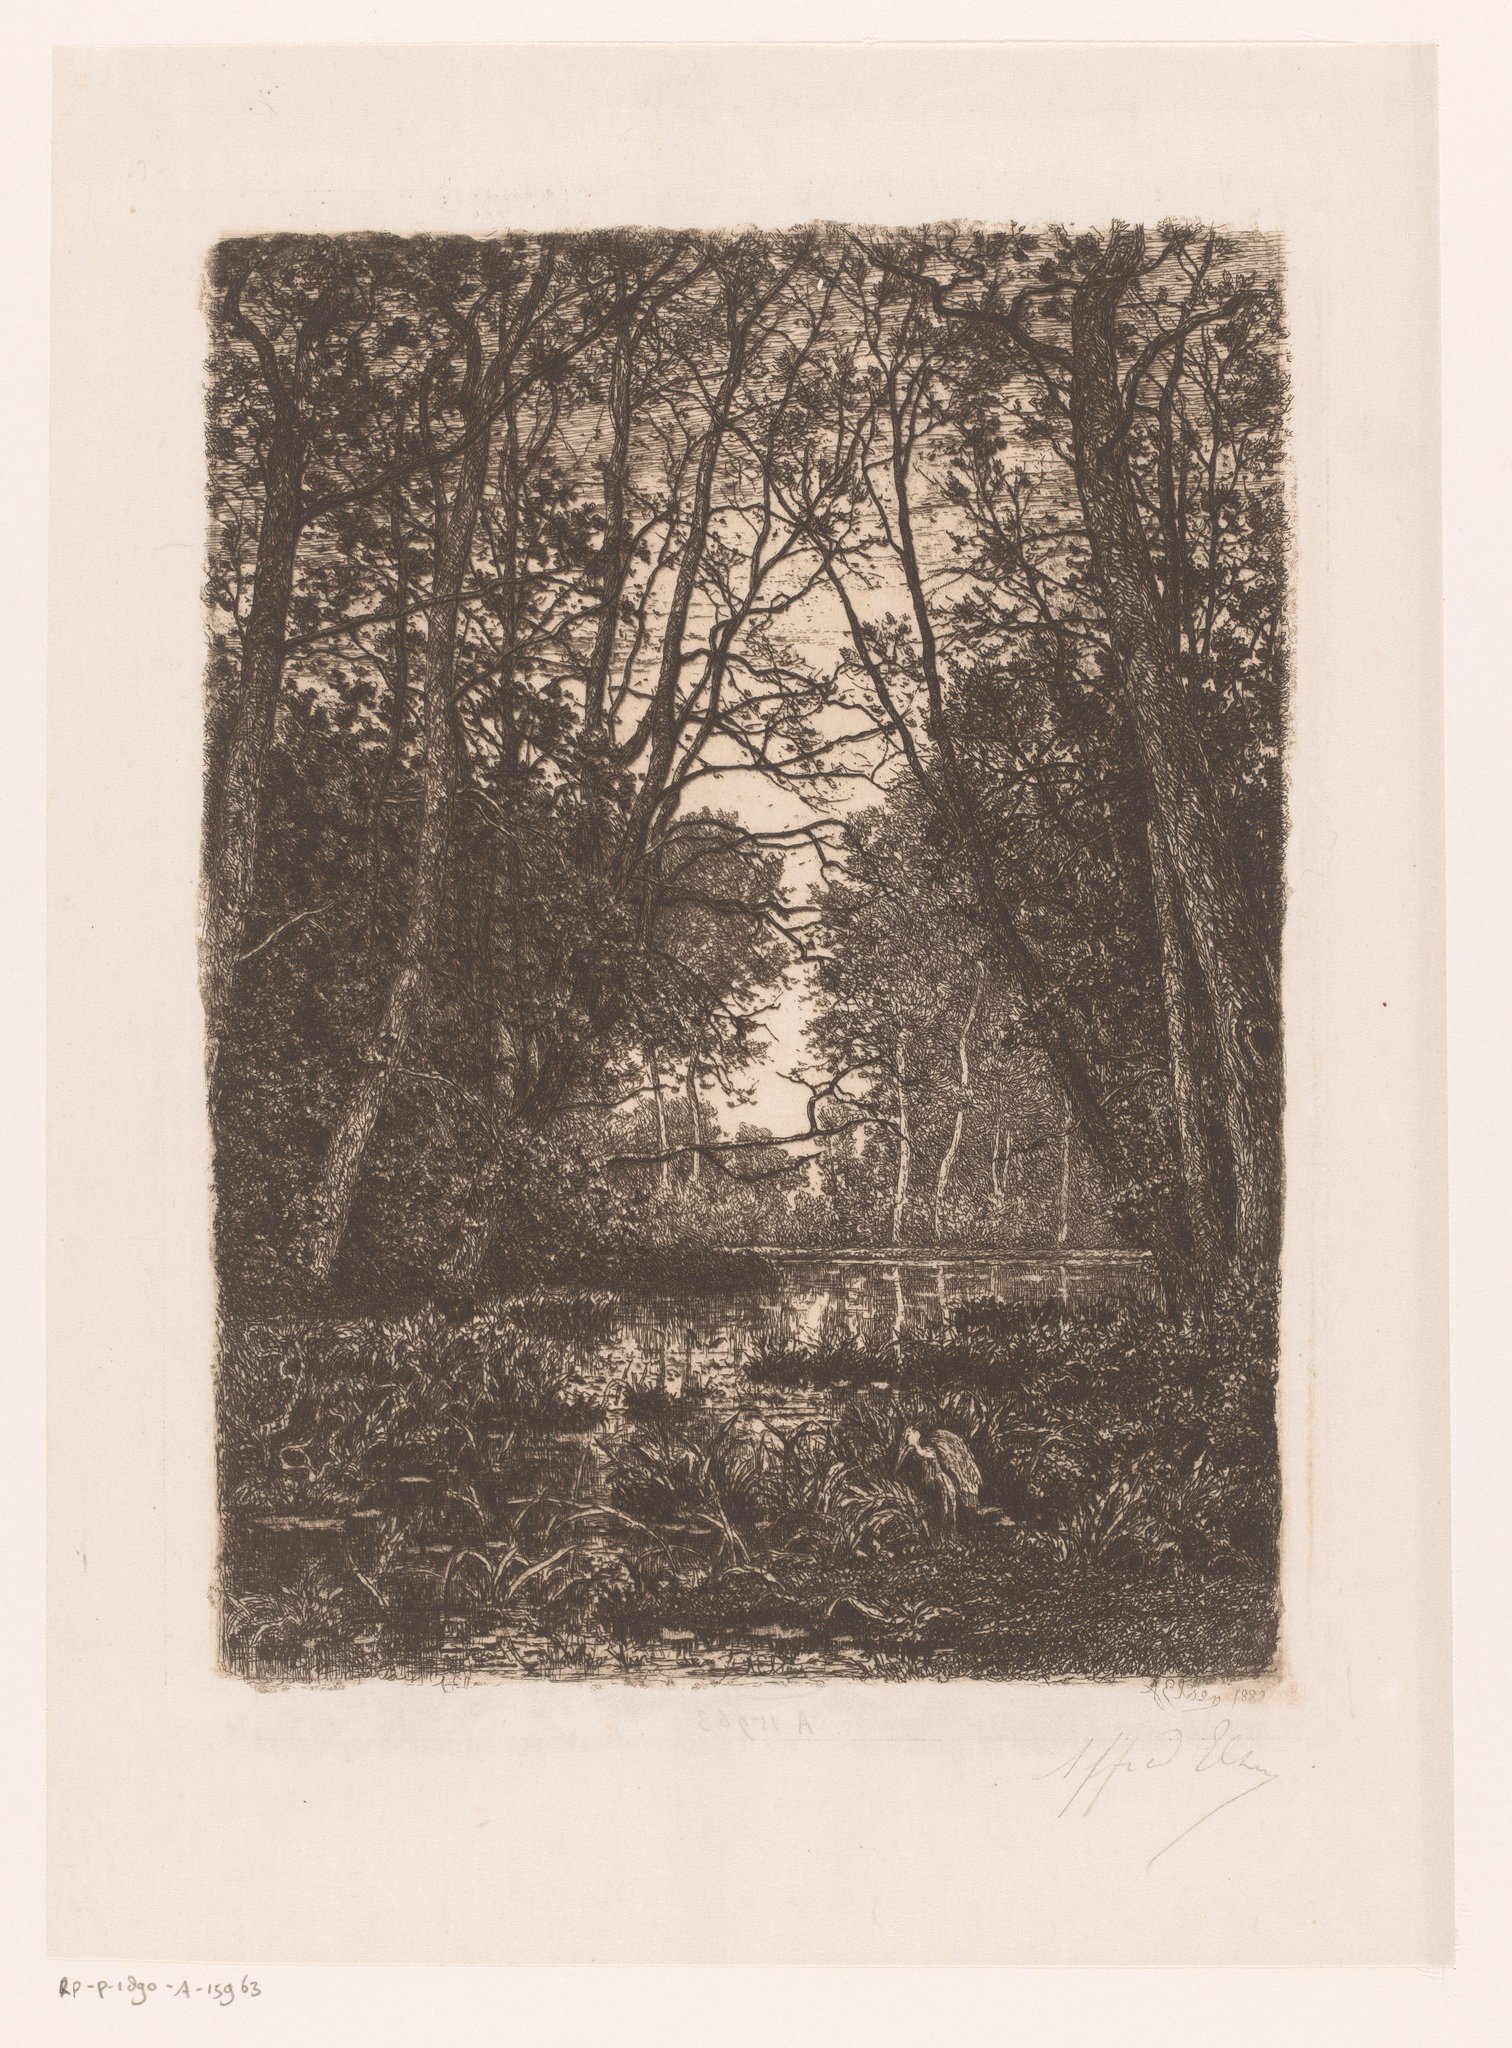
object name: print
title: Landschap met hoge bomen en een reiger rondom een waterplas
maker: alfred elsen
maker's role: painter, print maker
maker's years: 1850-1914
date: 1882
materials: paper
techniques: etching, intaglio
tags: shore-birds and wading-birds: heron, water course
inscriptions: mark: ‘Antwerpsche Etsers 1880’, collector's mark: Lugt 2228